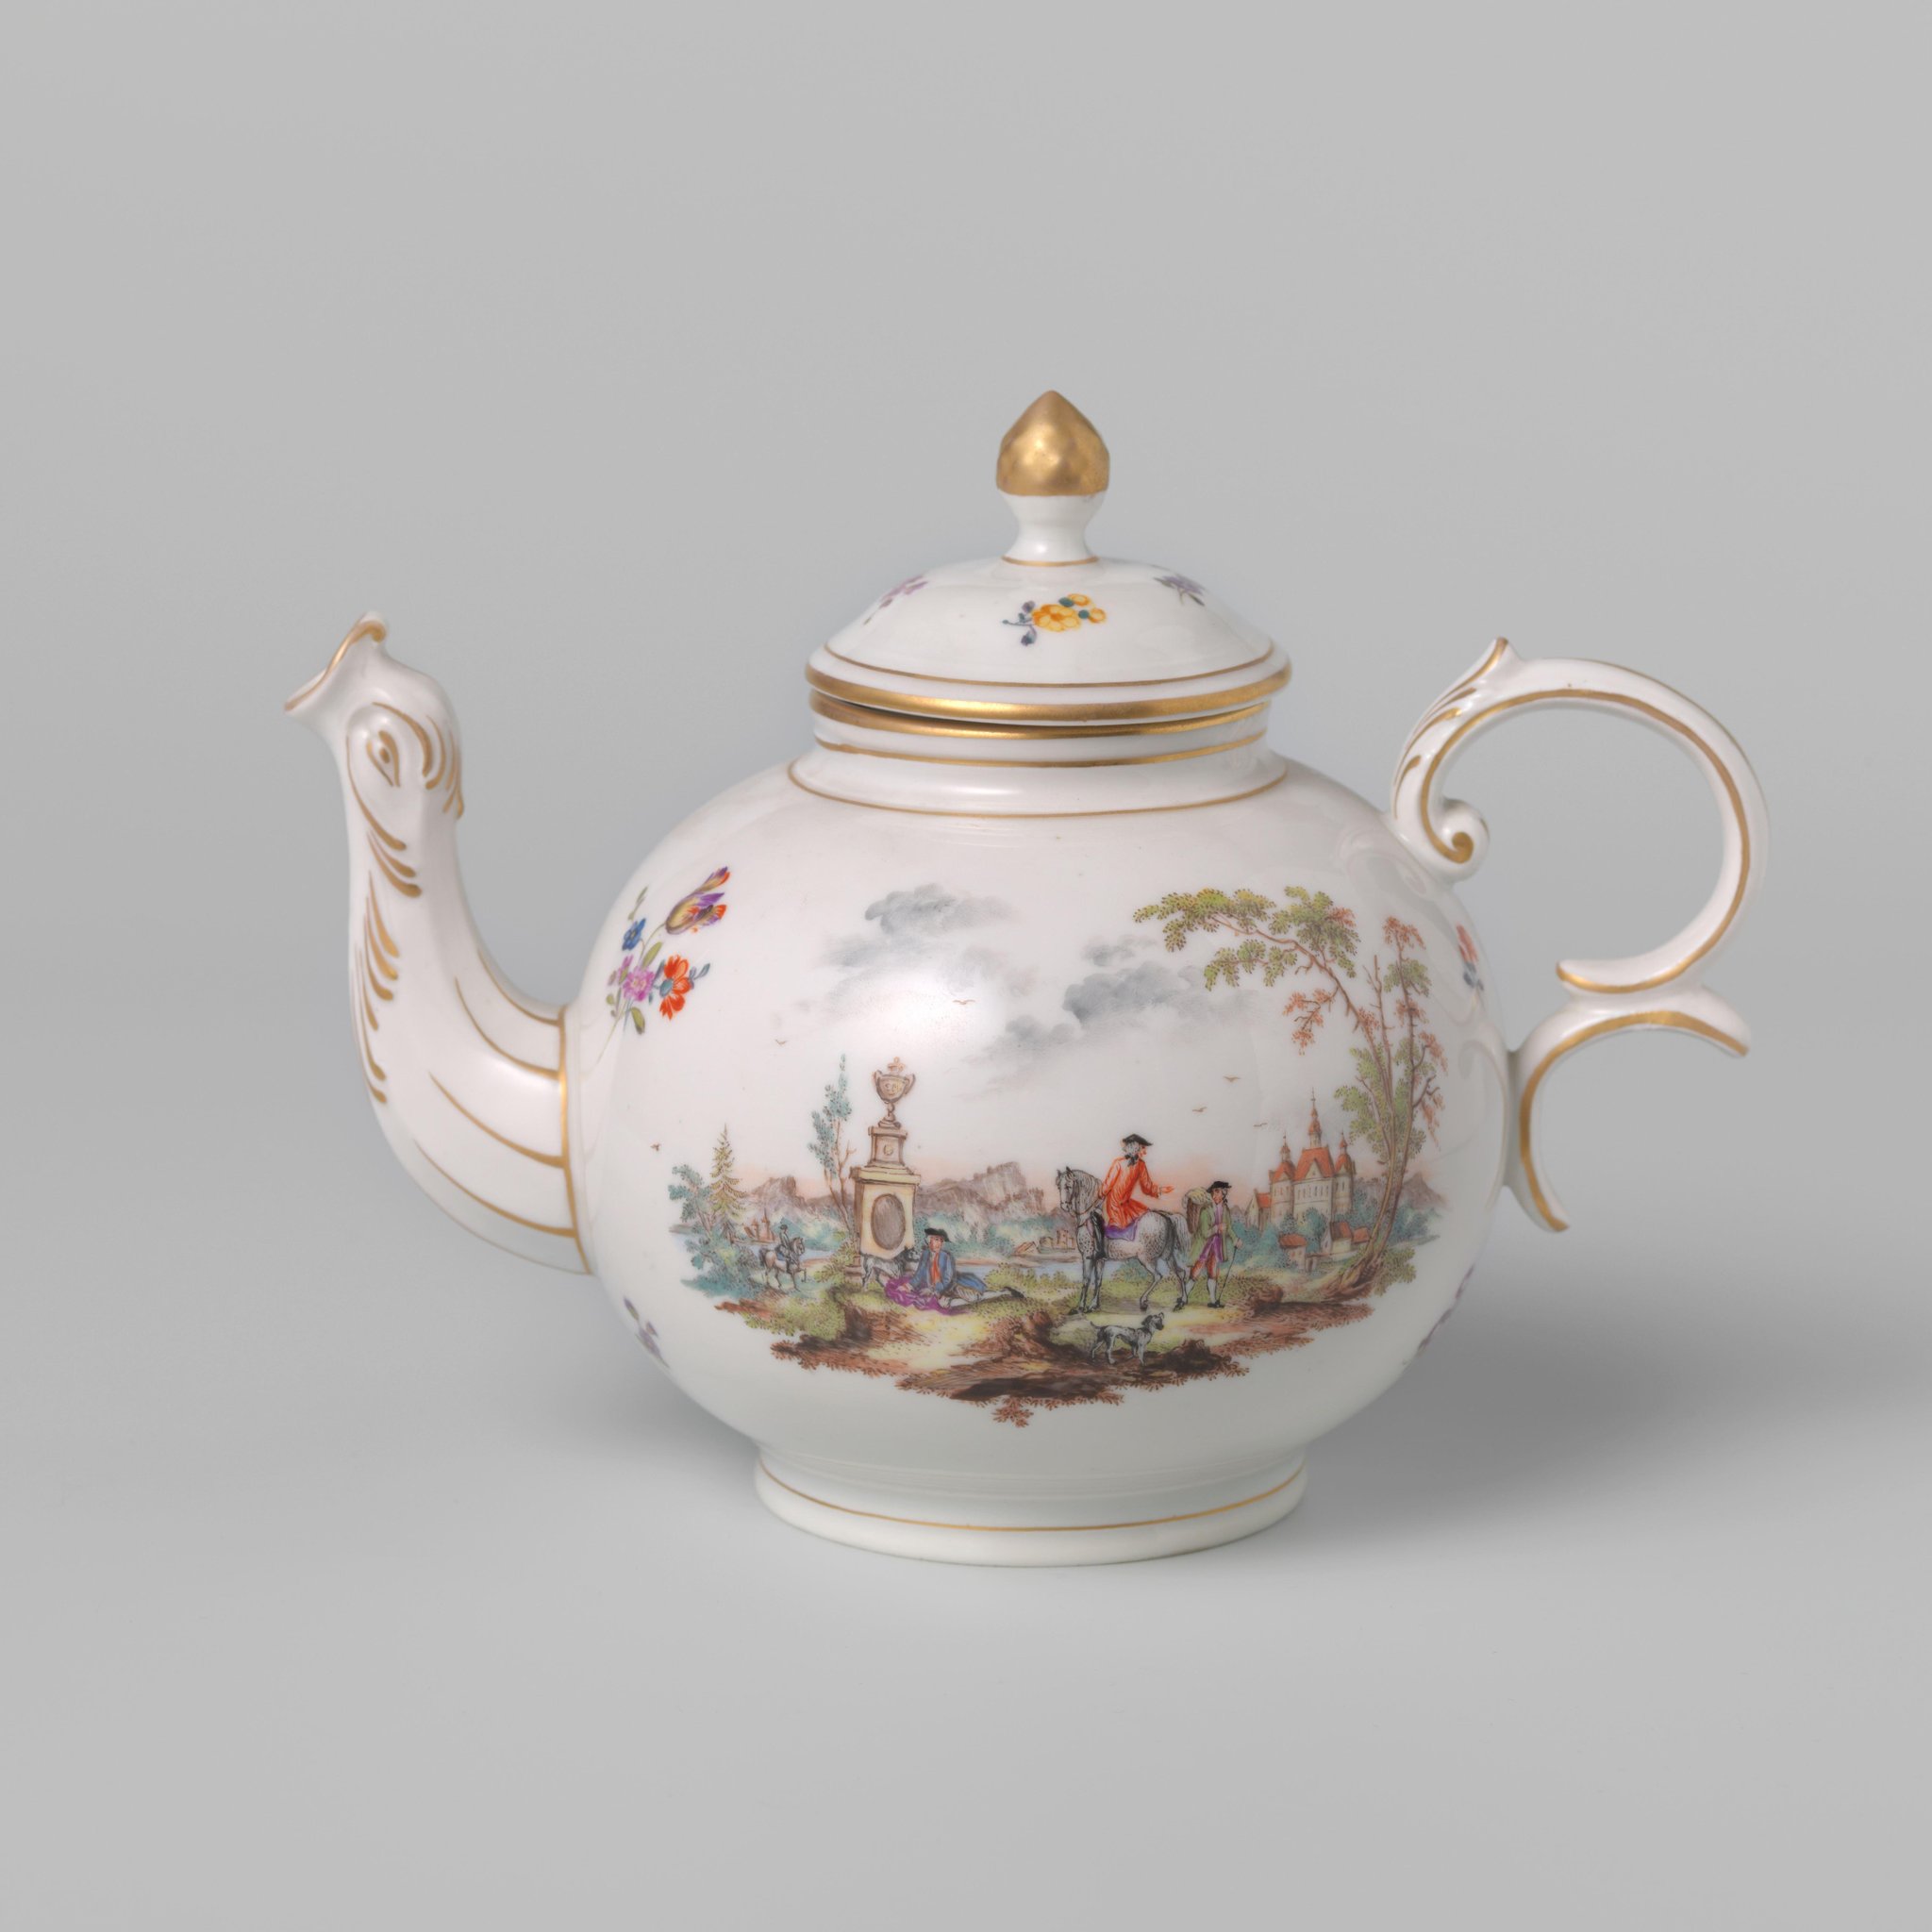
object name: lid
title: Cover of a teapot with flowers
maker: Anonymous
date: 1765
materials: glaze, gold, paint, porcelain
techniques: firing, forming, gilding, vitrification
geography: sint-petersburg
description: Deksel van een theepot van porselein, beschilderd op het glazuur in emailkleuren en goud. Versierd met strooibloemen en een puntige dekselknop. Gouden rand. Mogelijk een 19e of 20e eeuwse vervalsing.